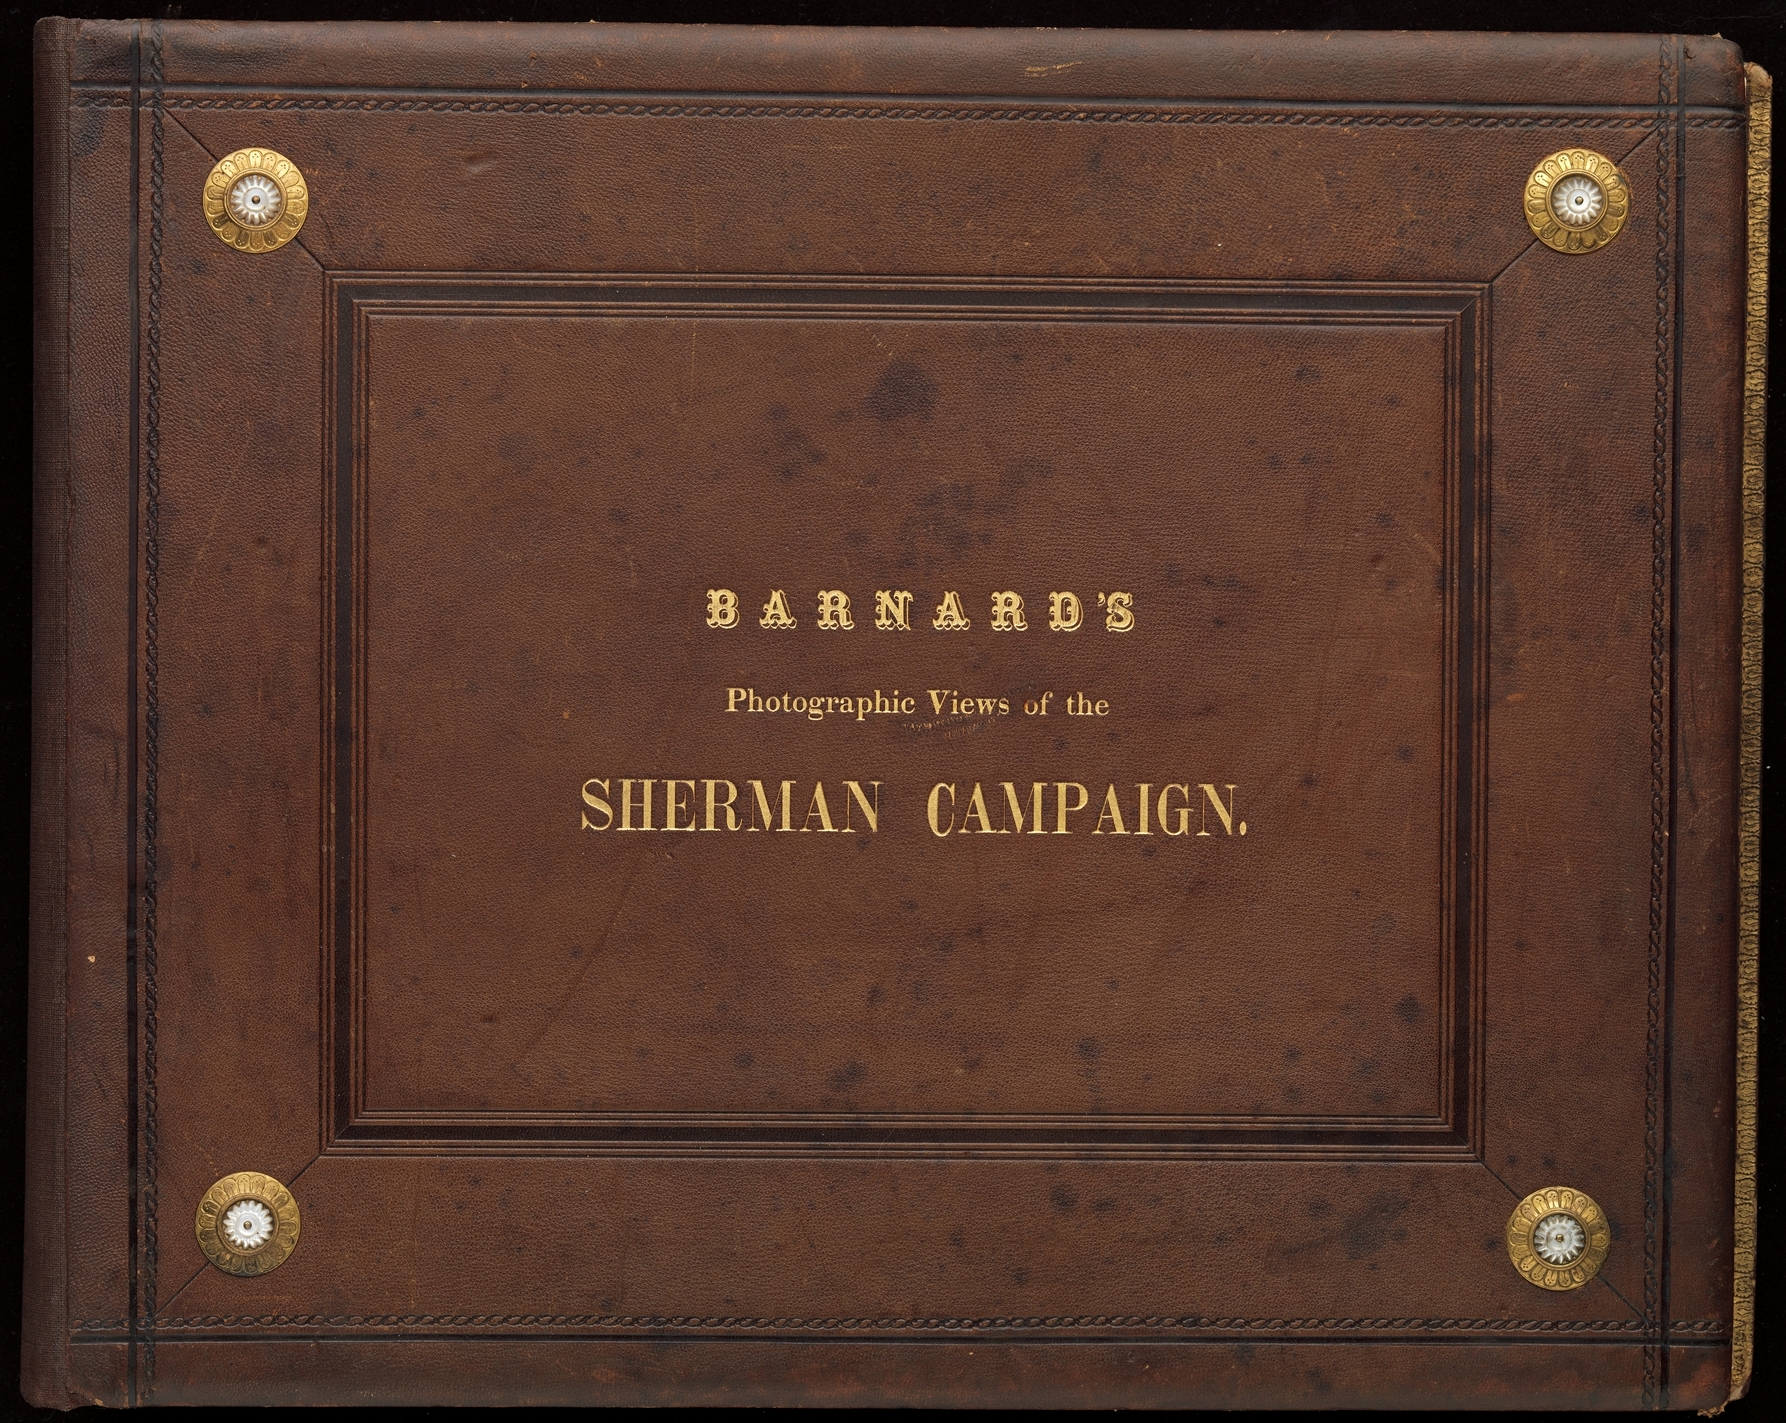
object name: album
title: Photographic Views of Sherman's Campaign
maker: george n. barnard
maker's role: artist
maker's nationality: american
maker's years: 1819-1902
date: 1860-1869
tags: american civil war